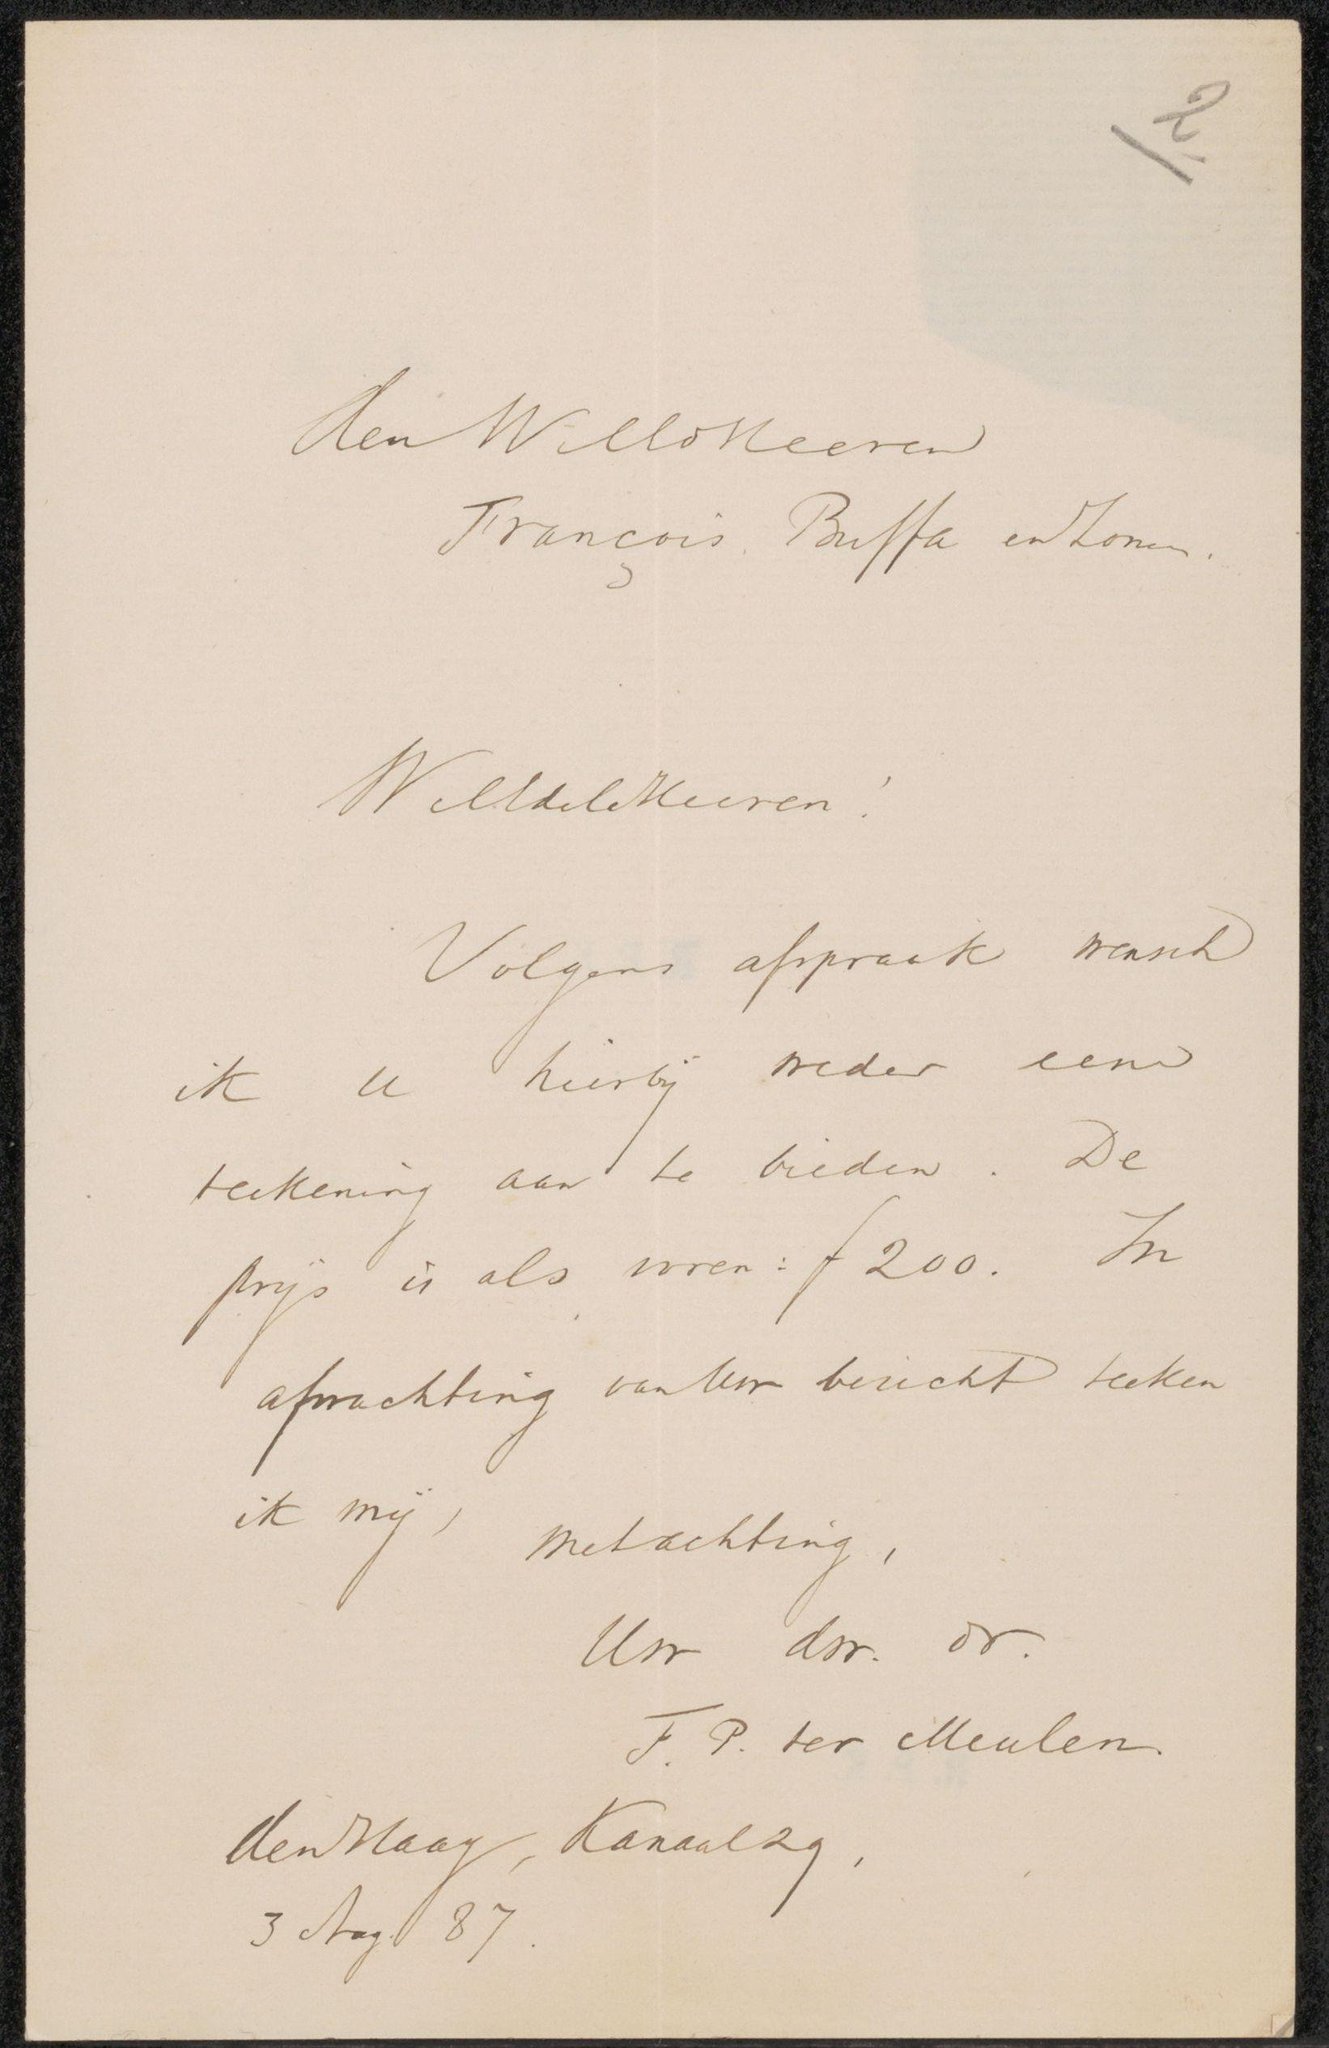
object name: letter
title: Brief aan Frans Buffa en Zonen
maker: françois pieter ter meulen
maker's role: painter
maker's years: 1843-1927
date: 1887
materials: ink, paper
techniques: pen, writing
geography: the hague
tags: publisher, art trade, art shop, drawing, money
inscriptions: collector's mark: Lugt 2233